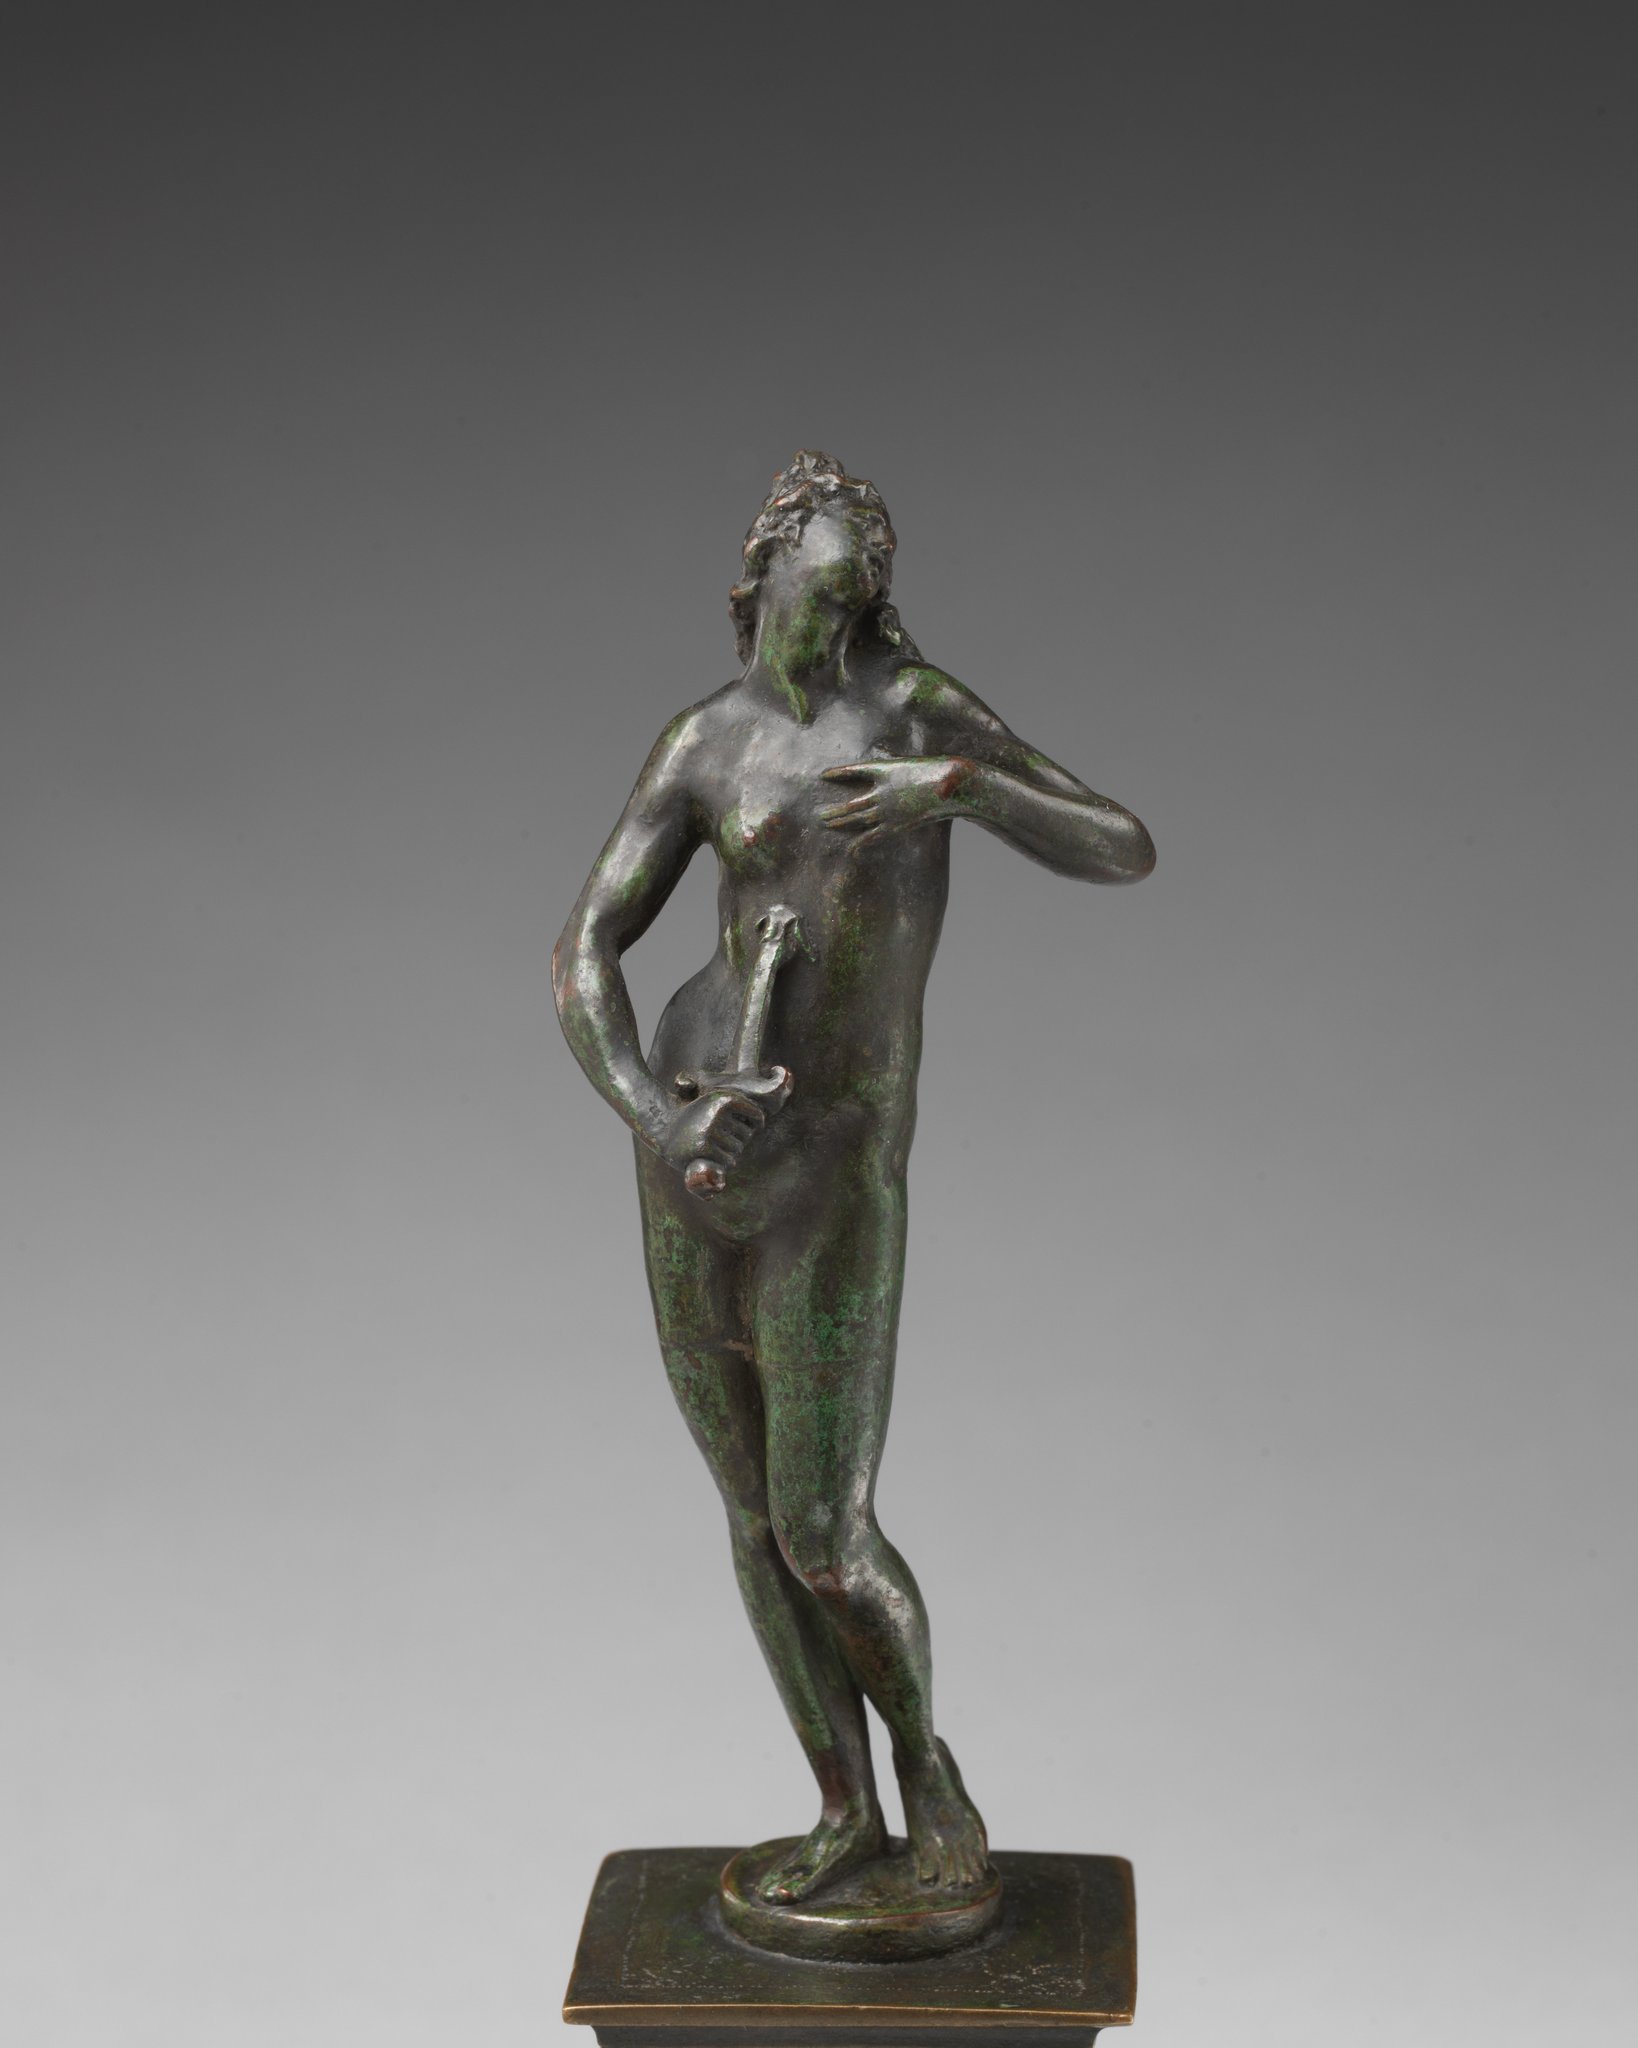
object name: statuette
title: Lucretia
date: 1551-1600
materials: bronze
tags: female nudes